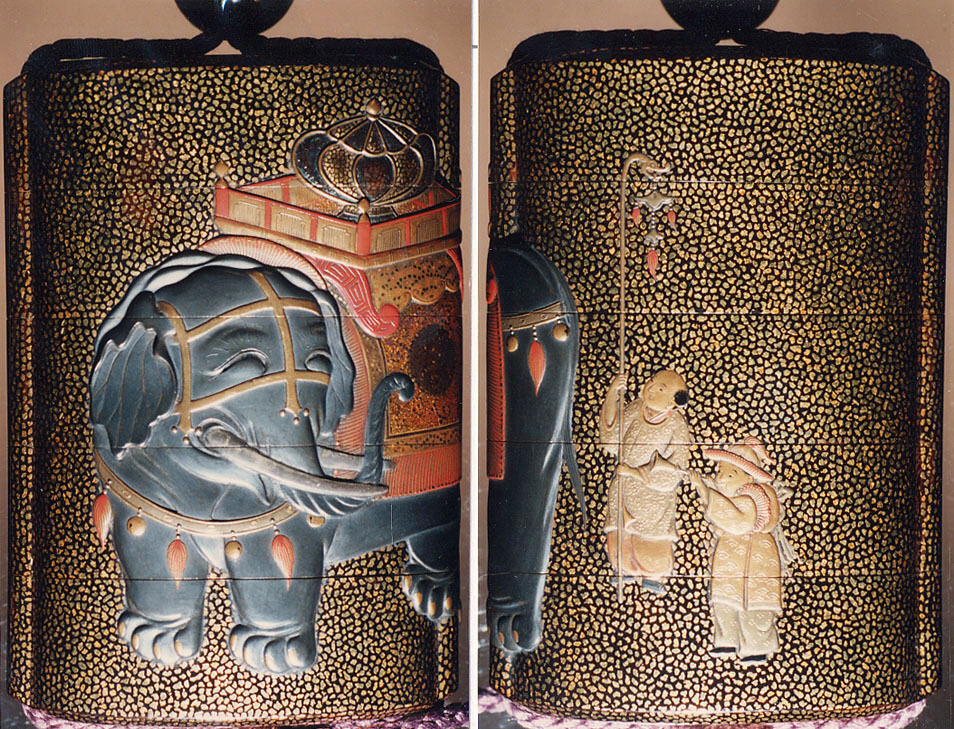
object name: inrō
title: Case (Inrō) with Design of Caparisoned Elephant Standing (obverse); Two Karako with Trumpet, Banner (reverse)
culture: japanese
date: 1801-1900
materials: gold, lacquer, metal, silver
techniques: fundame, hiramakie, roiro, maki-e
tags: men,trumpets,elephants